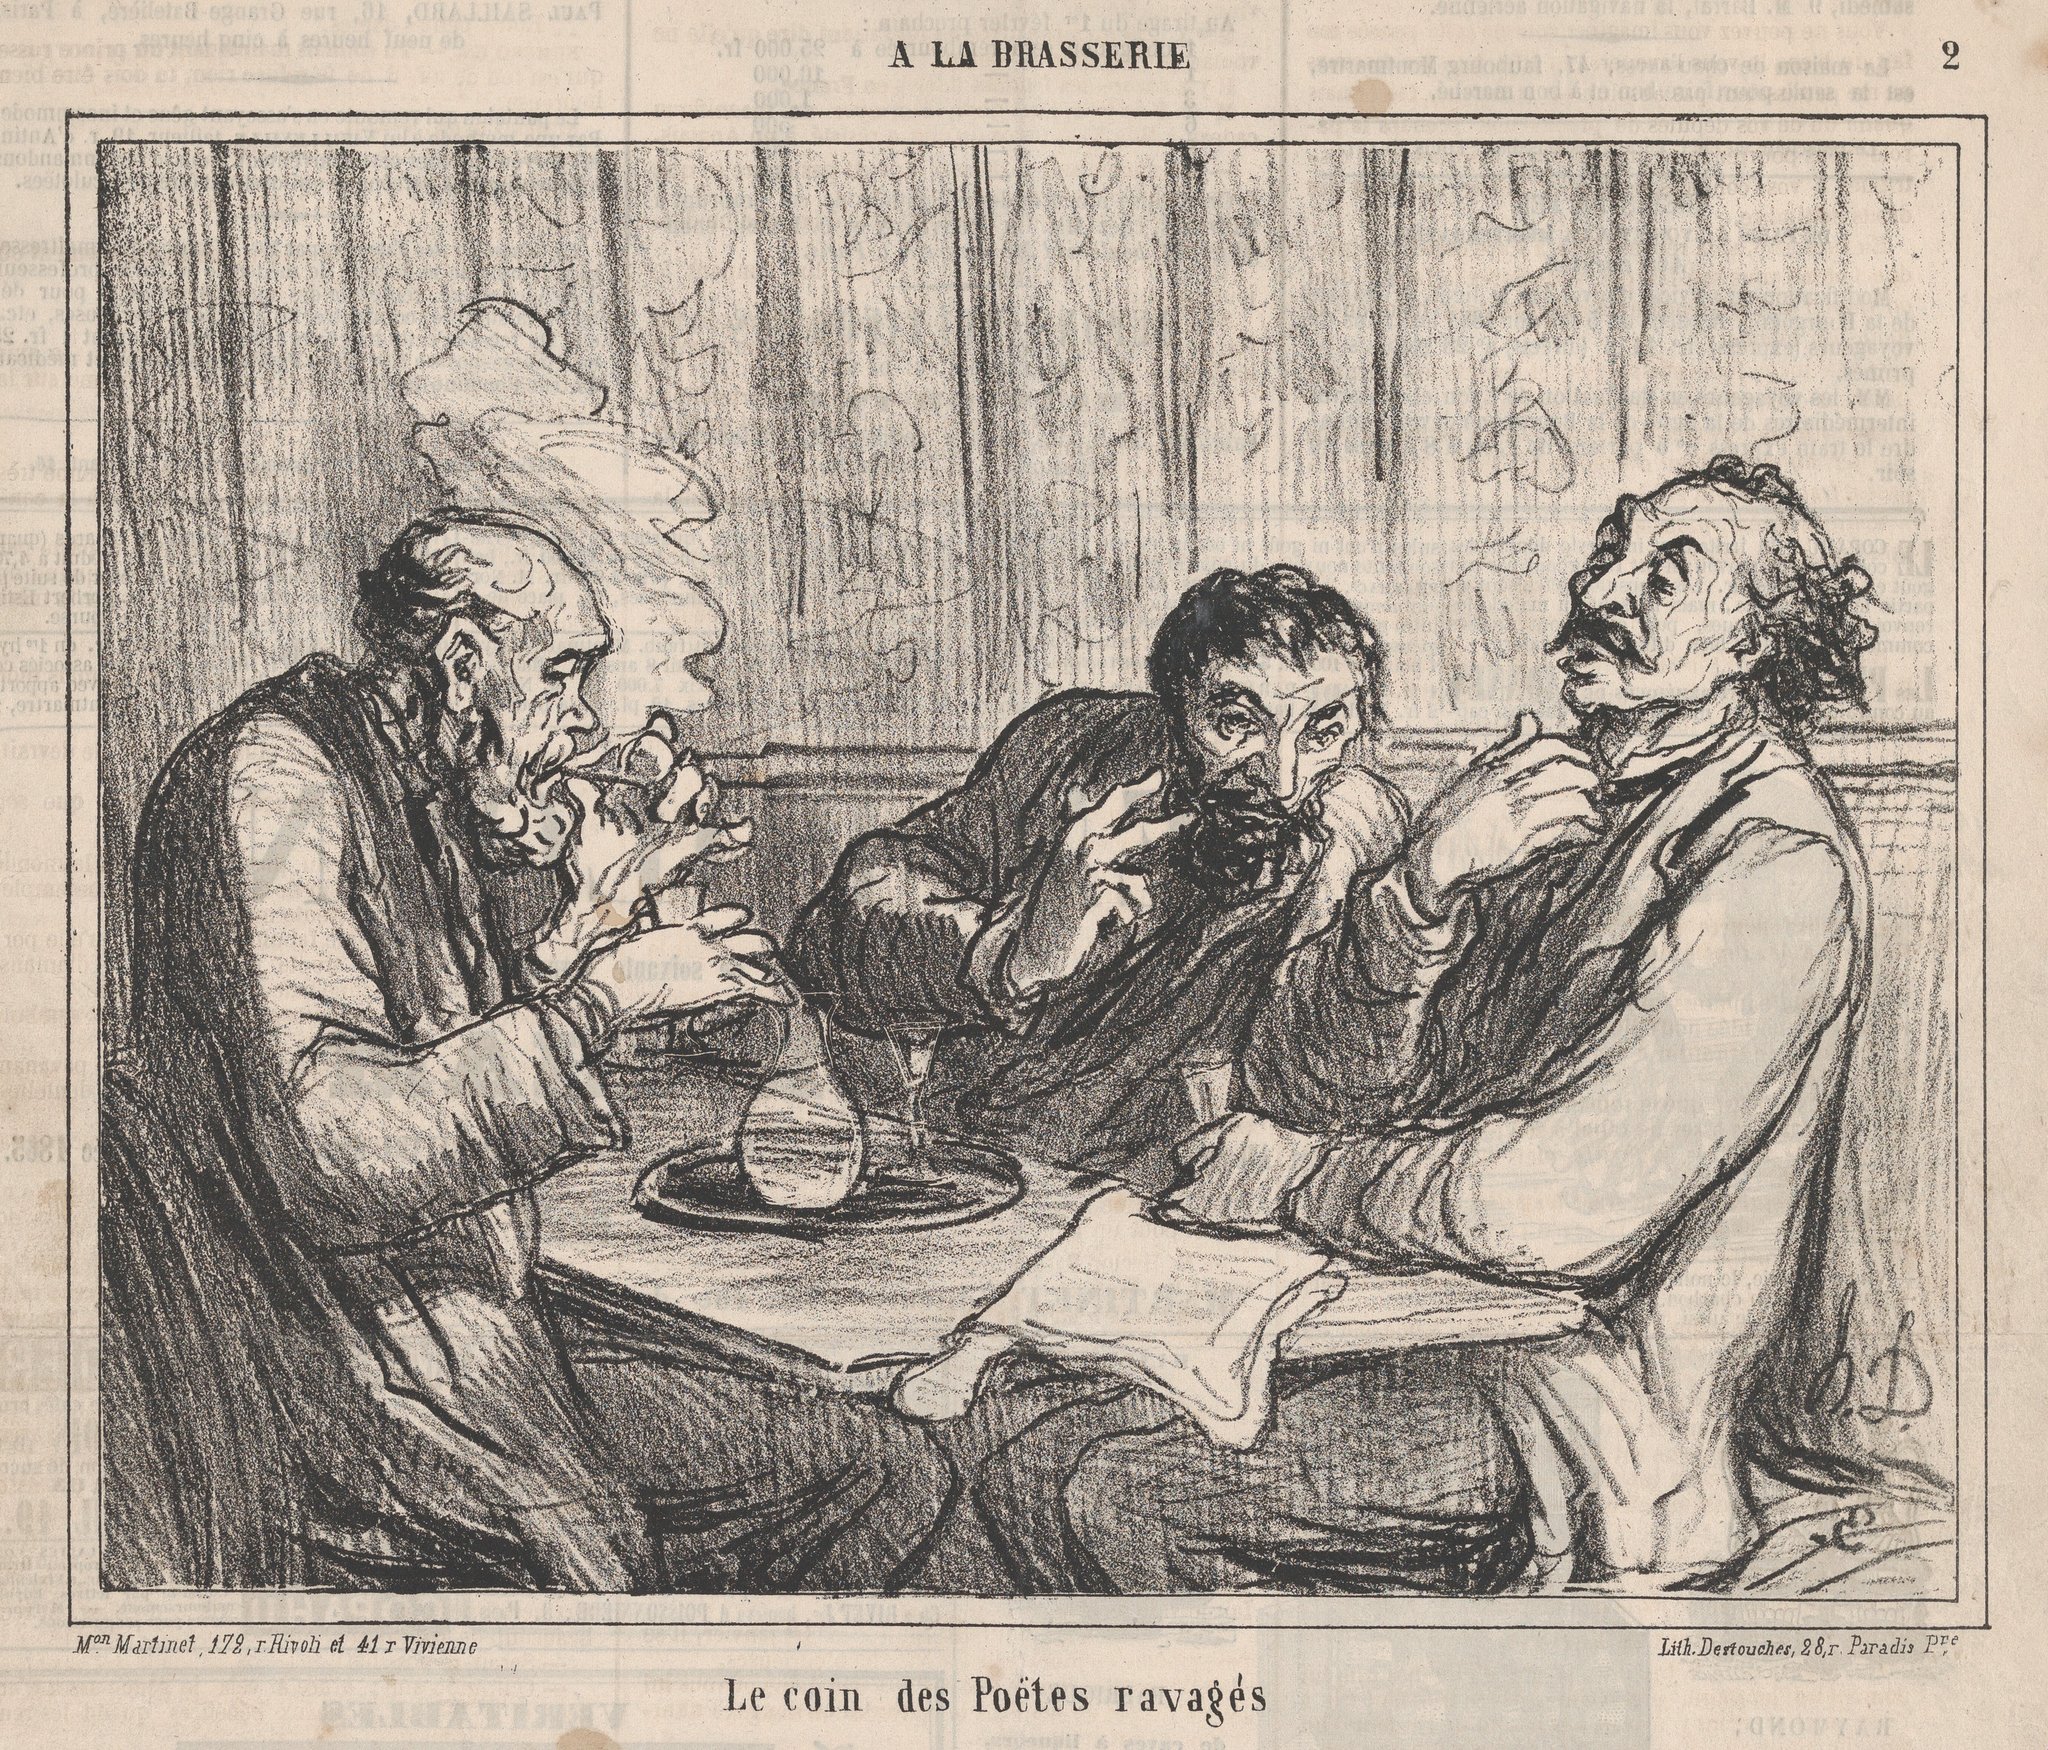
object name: print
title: The ravaged poets' corner, from 'In the pub,' published in Le Charivari, January 7, 1864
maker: honoré daumier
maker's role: artist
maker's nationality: french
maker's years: 1808-1879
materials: paper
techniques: lithograph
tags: taverns,men,smoking,poets